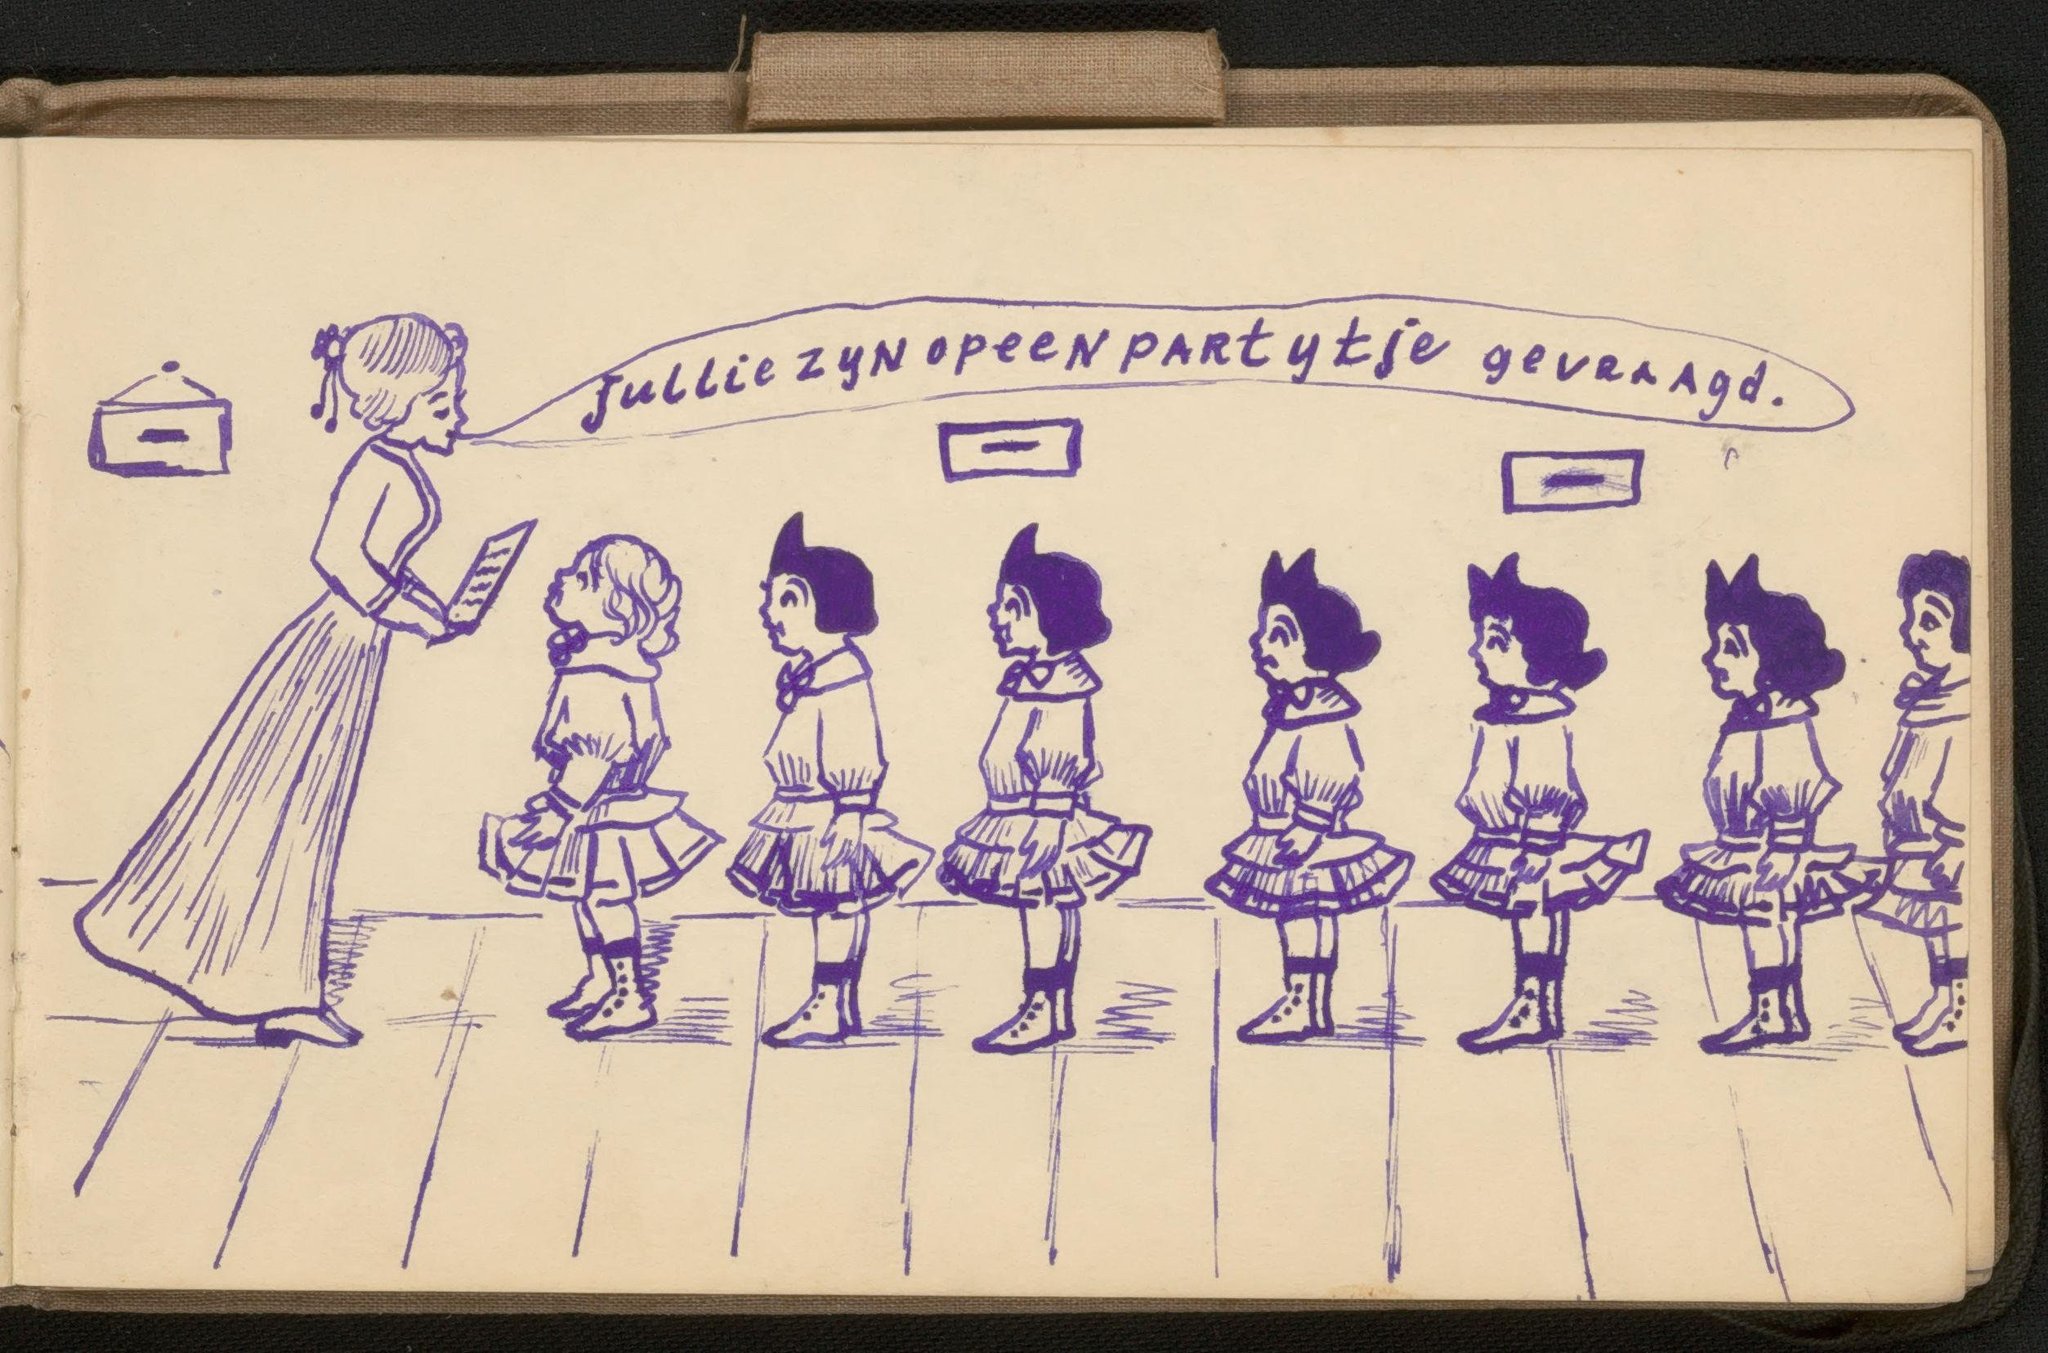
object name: sketchbook leaf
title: Uitgenodigd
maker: Anonymous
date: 1875-1920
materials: ink, paper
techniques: pen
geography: netherlands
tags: family life at home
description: De kinderen zijn uitgenodigd voor een partijtje. Onderdeel van het schetsboek met humoristische tekeningen over het leven van een 'famille nombreuse'. Onderwerpsrubrieken binnen de Atlas Zeden en Gewoonten: Zeden en Gewoonten in Engeren Zin, Des menschen beging, midden en einde, Kinderleven.